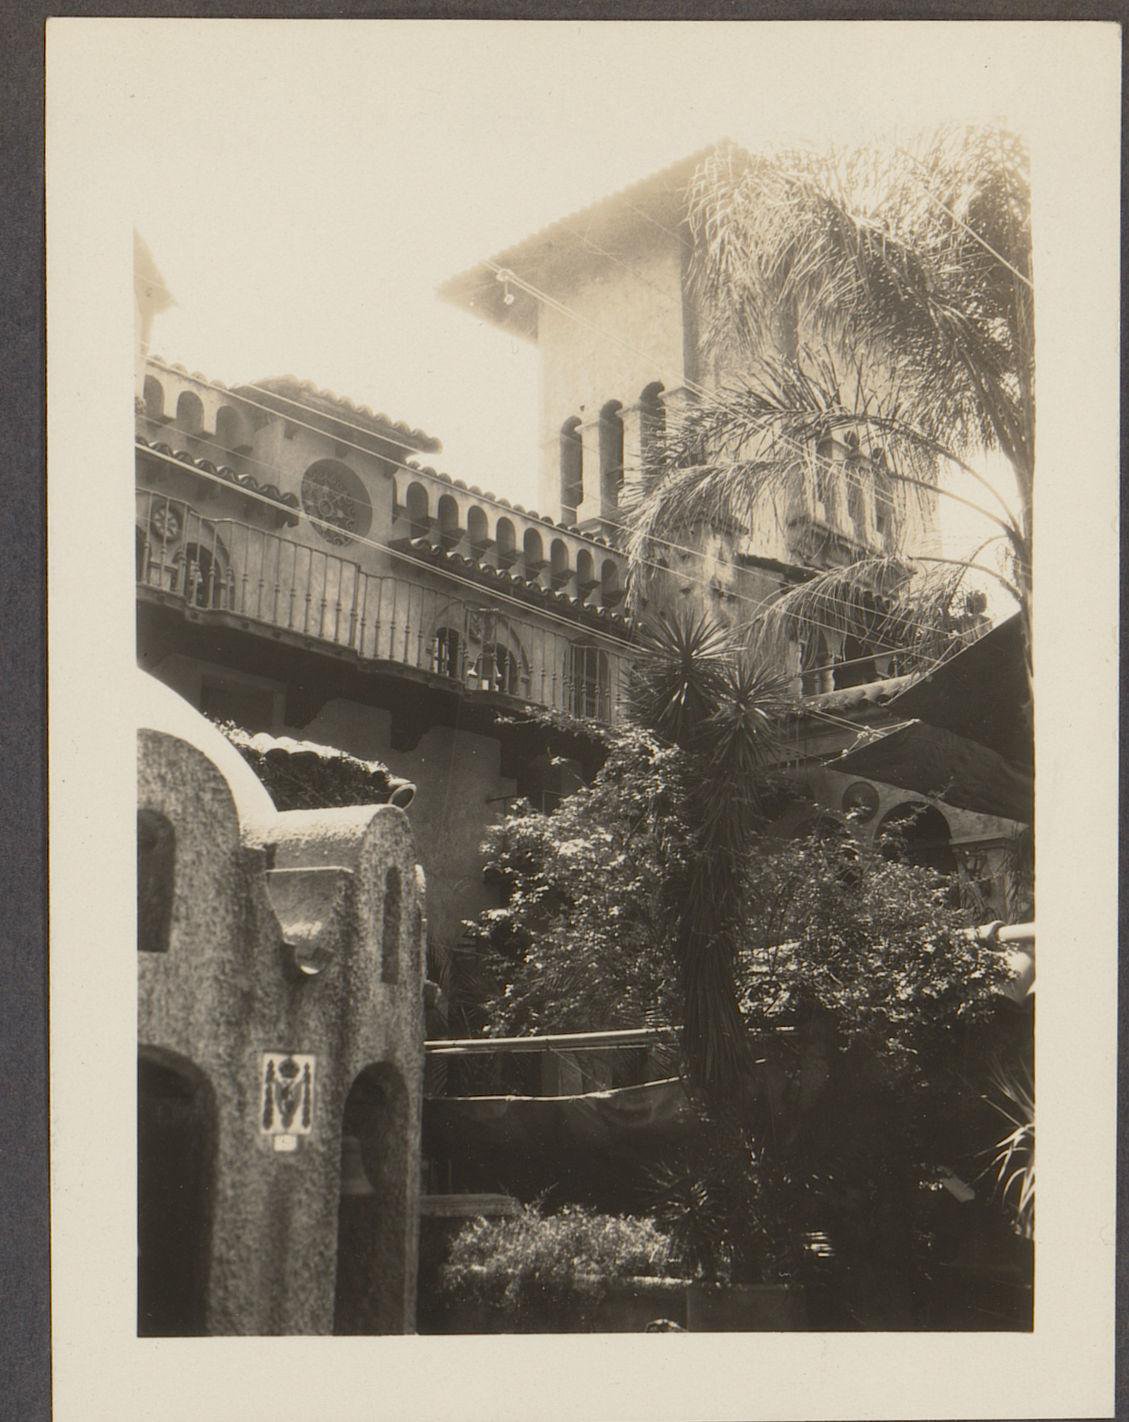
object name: album leaf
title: Mission Inn te Riverside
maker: Anonymous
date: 1928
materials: photographic support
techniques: gelatin silver print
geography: riverside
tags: hotel, hostelry, inn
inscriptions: annotation: ‘Mission Inn Riverside’